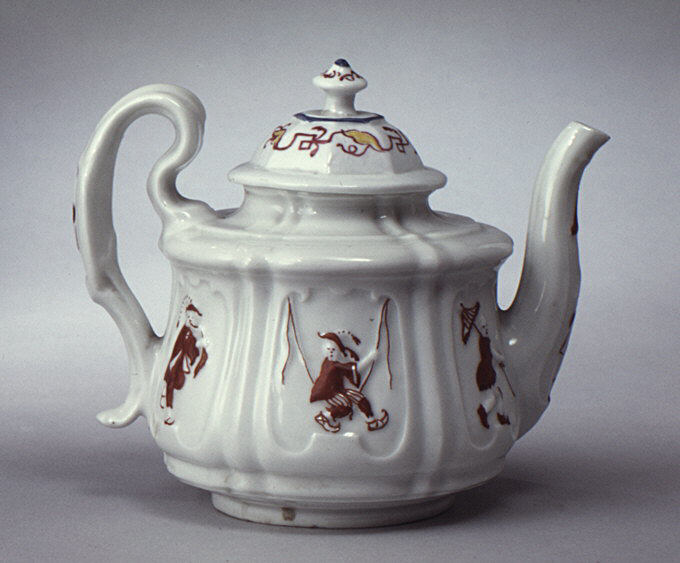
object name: teapot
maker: vezzi factory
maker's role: factory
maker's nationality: italian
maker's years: 1720-1727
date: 1720-1727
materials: hard paste porcelain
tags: men